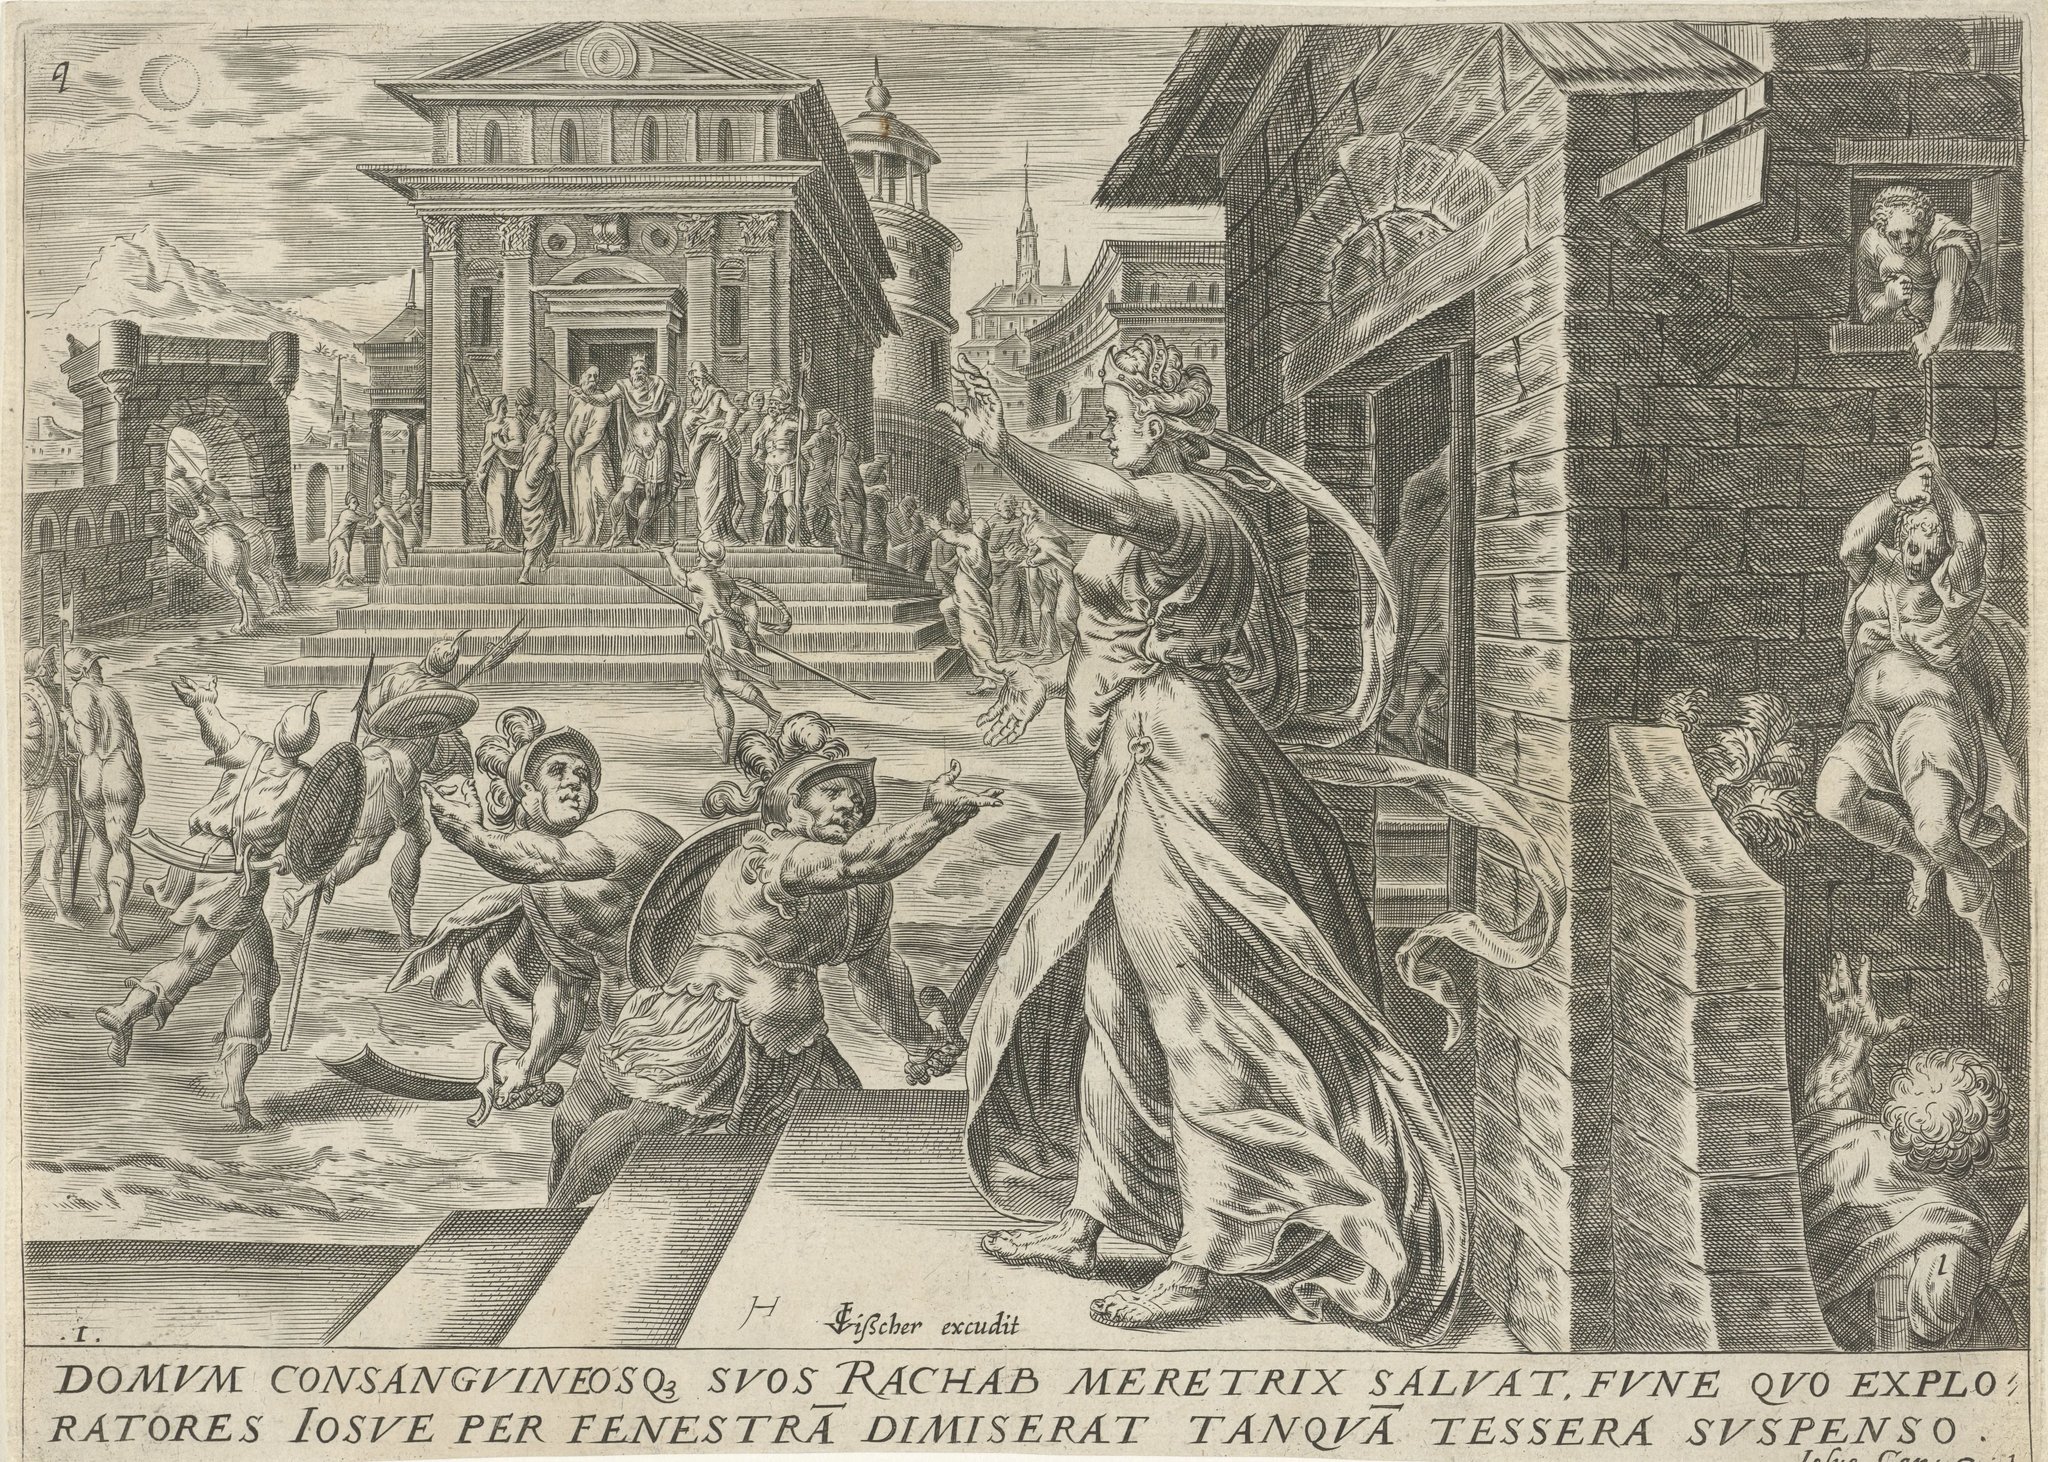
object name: print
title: Rachab laat de spionnen door het raam ontsnappen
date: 1567-1570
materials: paper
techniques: engraving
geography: amsterdam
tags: rahab, questioned by the king's men about the israelite spies, sends them on a false track, rahab, whose house was built in the city wall, lets the spies down from the window by means of a red rope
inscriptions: collector's mark: Lugt 2228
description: Prent mogelijk gebruikt in: Piscator, Nicolaus Johannes. Theatrum biblicum hoc est Historiæ sacræ Veteris et Novi Testamenti tabulis æneis expressæ. Amsterdam: Claes Jansz. Visscher, 1639 en 1643, Amsterdam: Nicolaes Visscher, 1674. Of in: Schabaelje, Jan Philipsz. Den grooten figver-bibel. Dat is een afbeeldingh en levendighe vertooningh, van alle de voornaemste historien (...) der gantscher Heyliger Schrift, in schoone copere figueren (...) verrijckt met leersame verclaeringhen over de selve figueren. Alkmaar: Simon Cornelisz Brekegeest, Amsterdam: Jan Philipsz. Schabaelje, 1646.